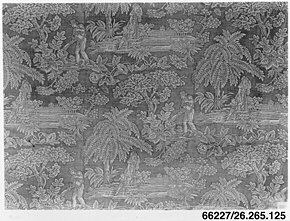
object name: furnishing textile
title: Pictorial print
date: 1815-1825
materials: cotton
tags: human figures,flowers,trees